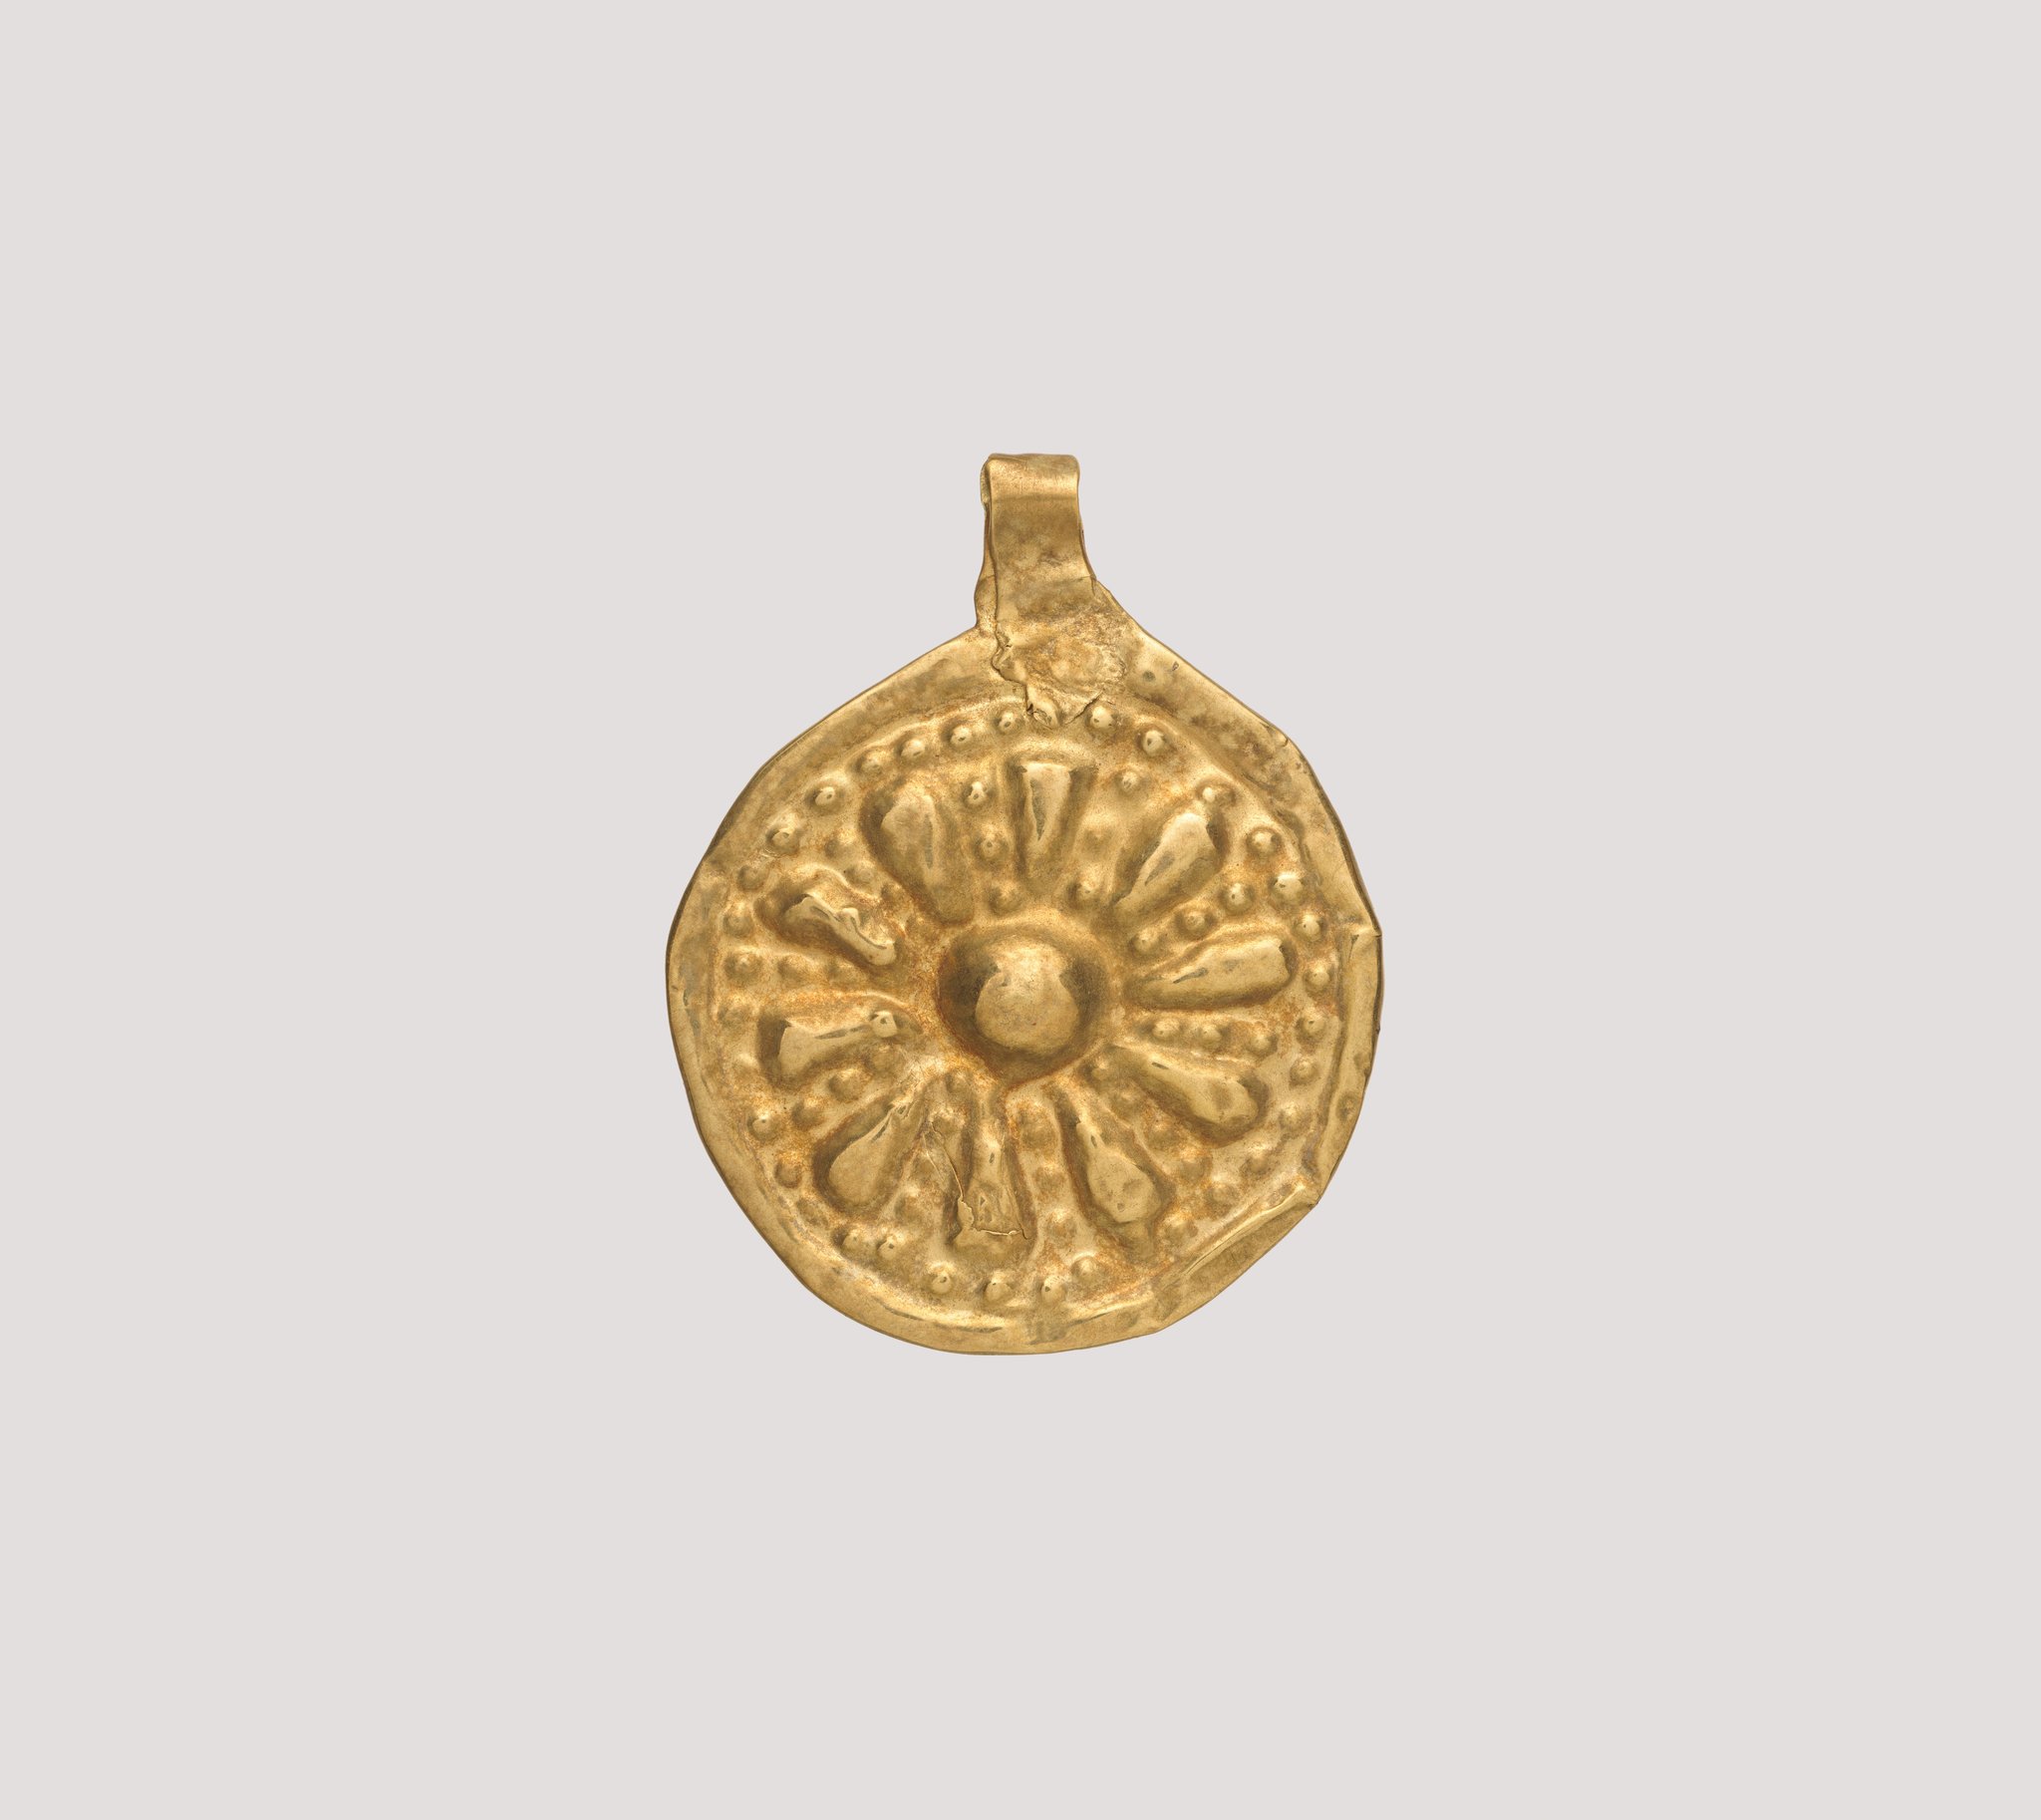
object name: pendant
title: Rosette pendant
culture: iranian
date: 900-801 BCE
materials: gold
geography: iran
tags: flowers